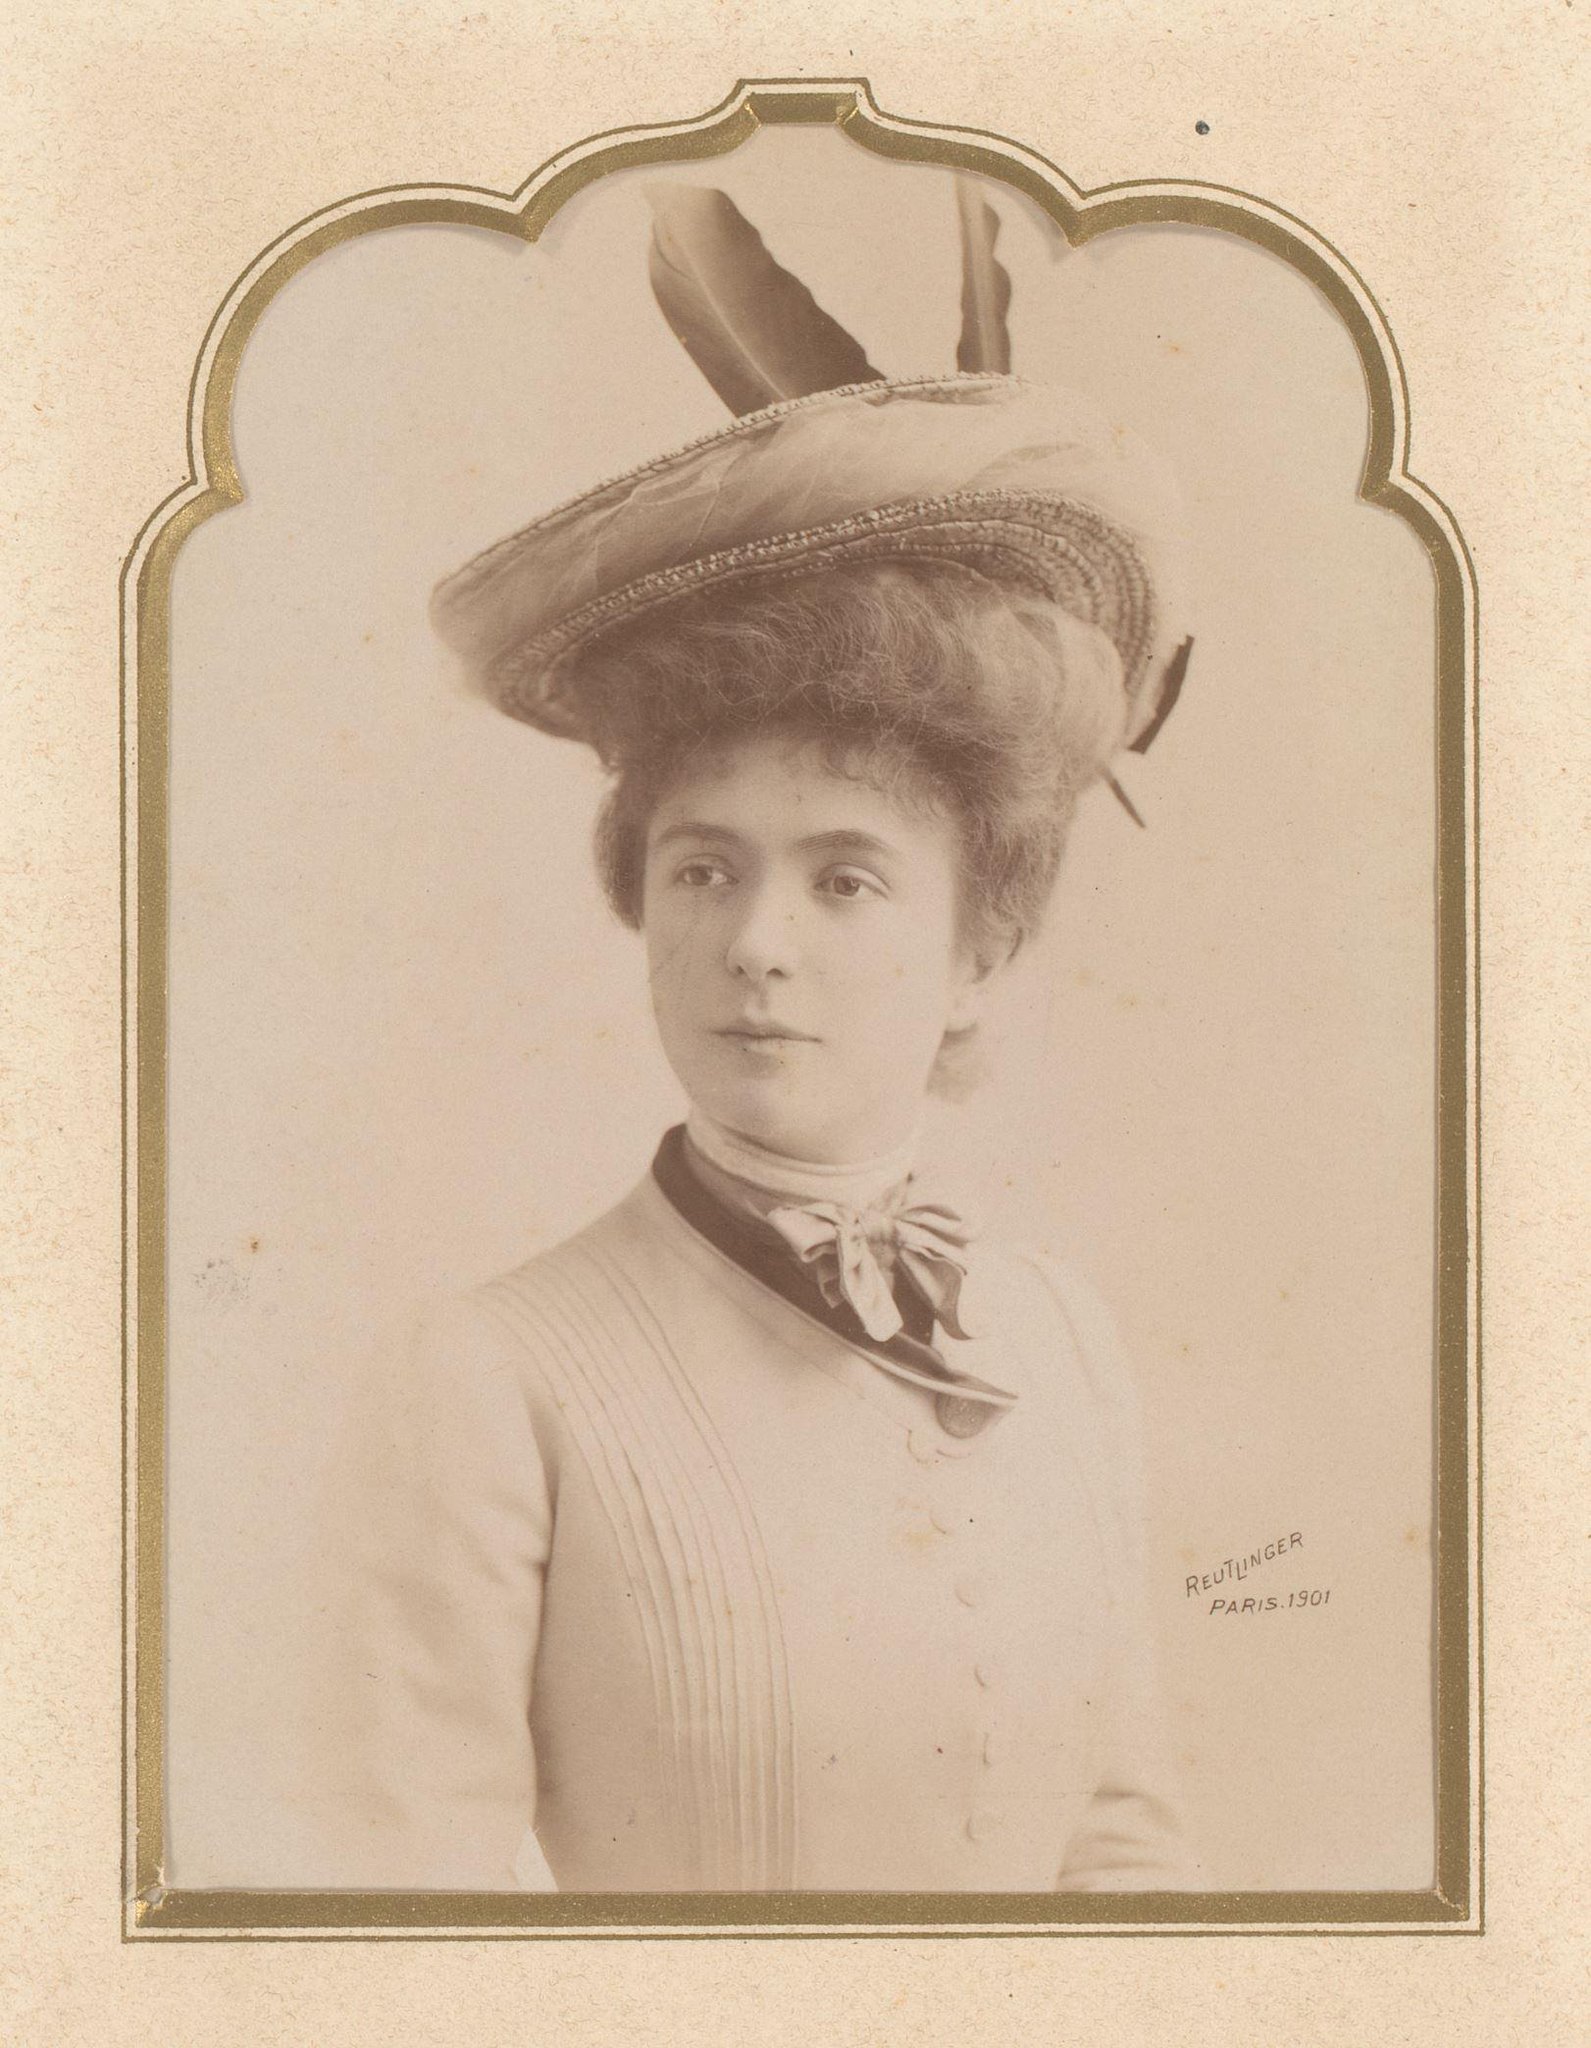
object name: photograph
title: Portret van een vrouw met hoed met veren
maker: charles reutlinger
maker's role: publisher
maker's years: 1816-1880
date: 1901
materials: cardboard, photographic support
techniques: albumen print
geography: paris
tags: historical persons - bb - woman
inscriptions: inscription: ‘536/ Année 1901/ Numero 413/ Lettre X’, inscription: ‘Reutlinger/ 21, Boulevard Montmartre/ Paris/ 2e Arrond. (...)’